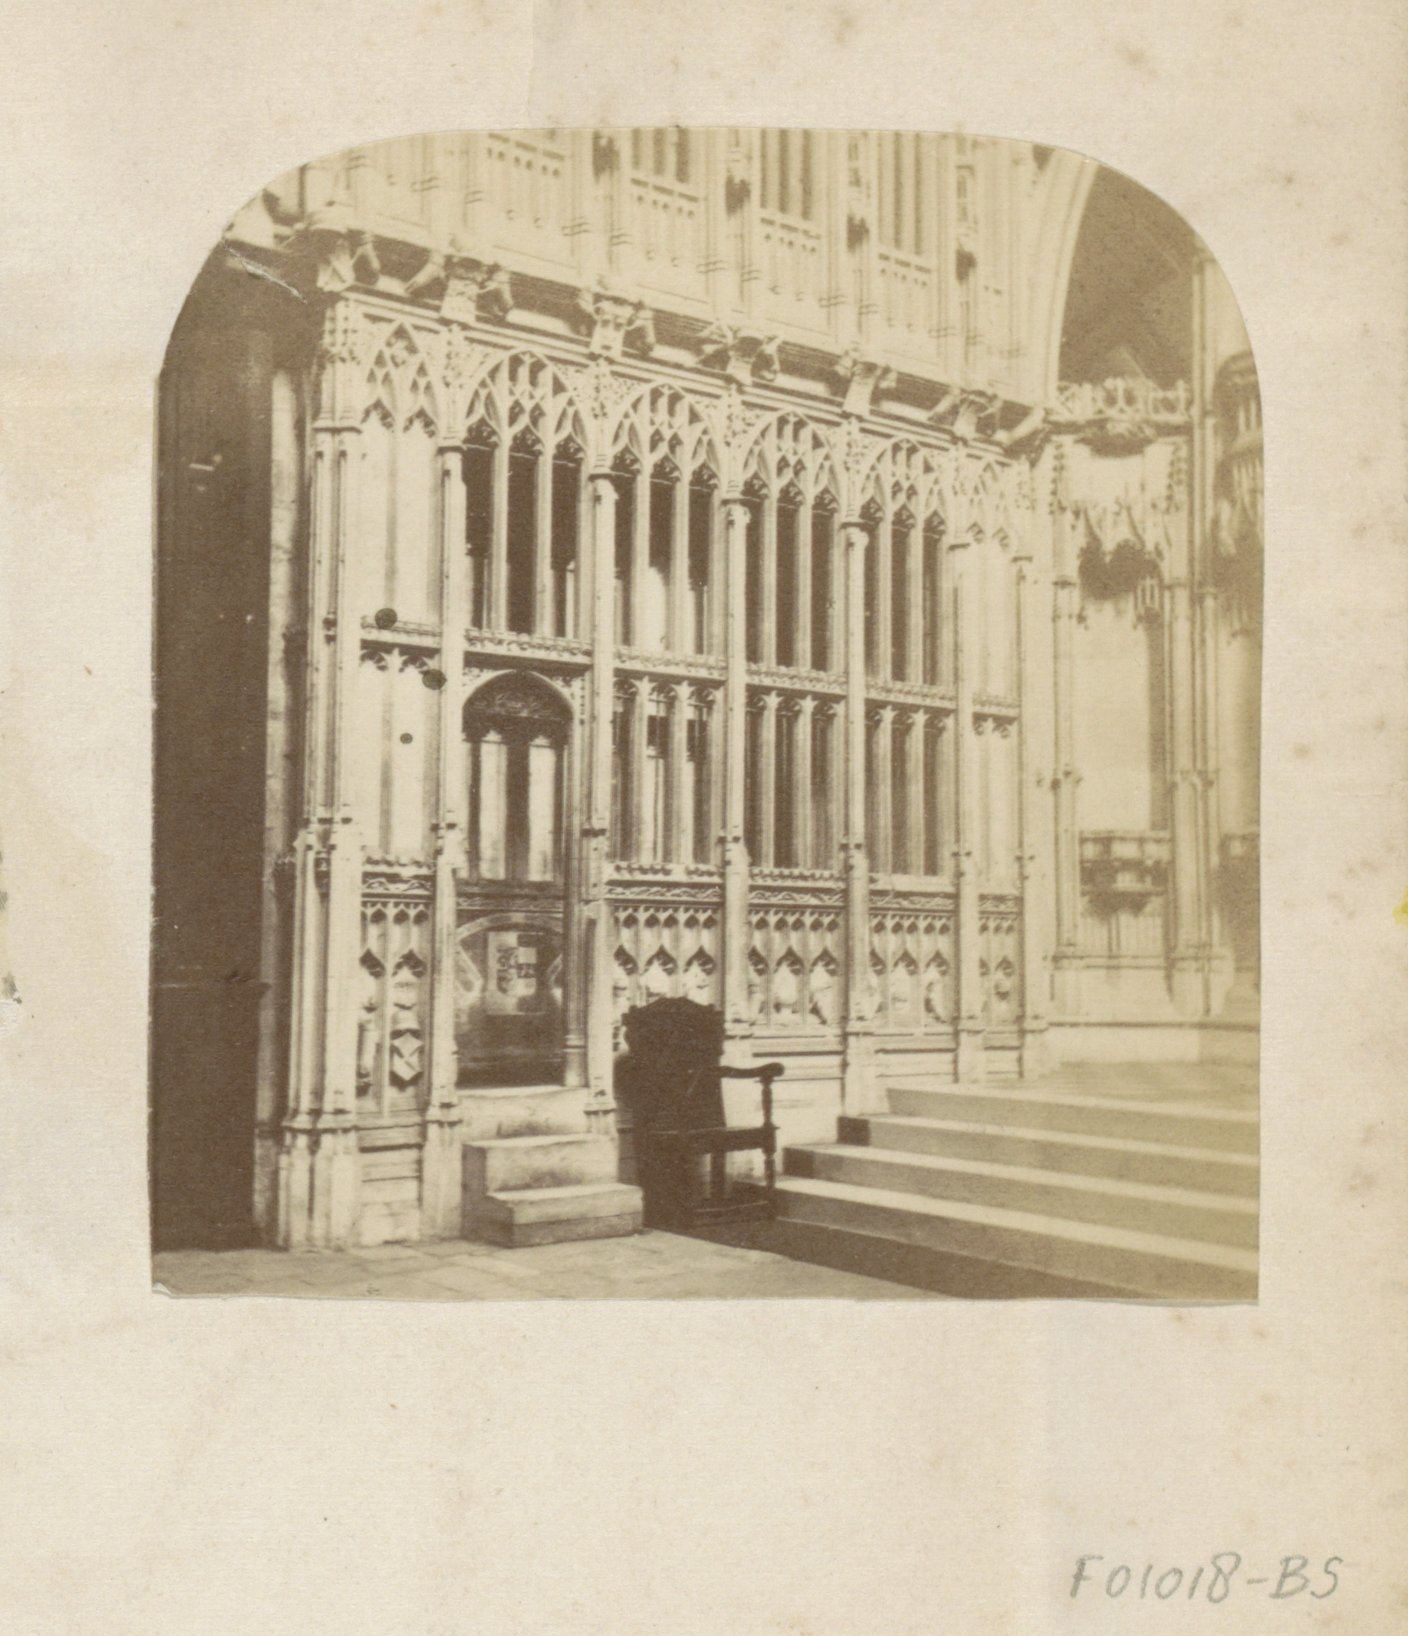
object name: photograph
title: Gotisch koor van een kerk in Engeland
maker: Anonymous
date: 1860-1870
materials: paper, photographic support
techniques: albumen print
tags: parts of church interior: choir, england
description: Onderdeel van Engels familiealbum met foto's van personen, reizen, cricket en kunstwerken.